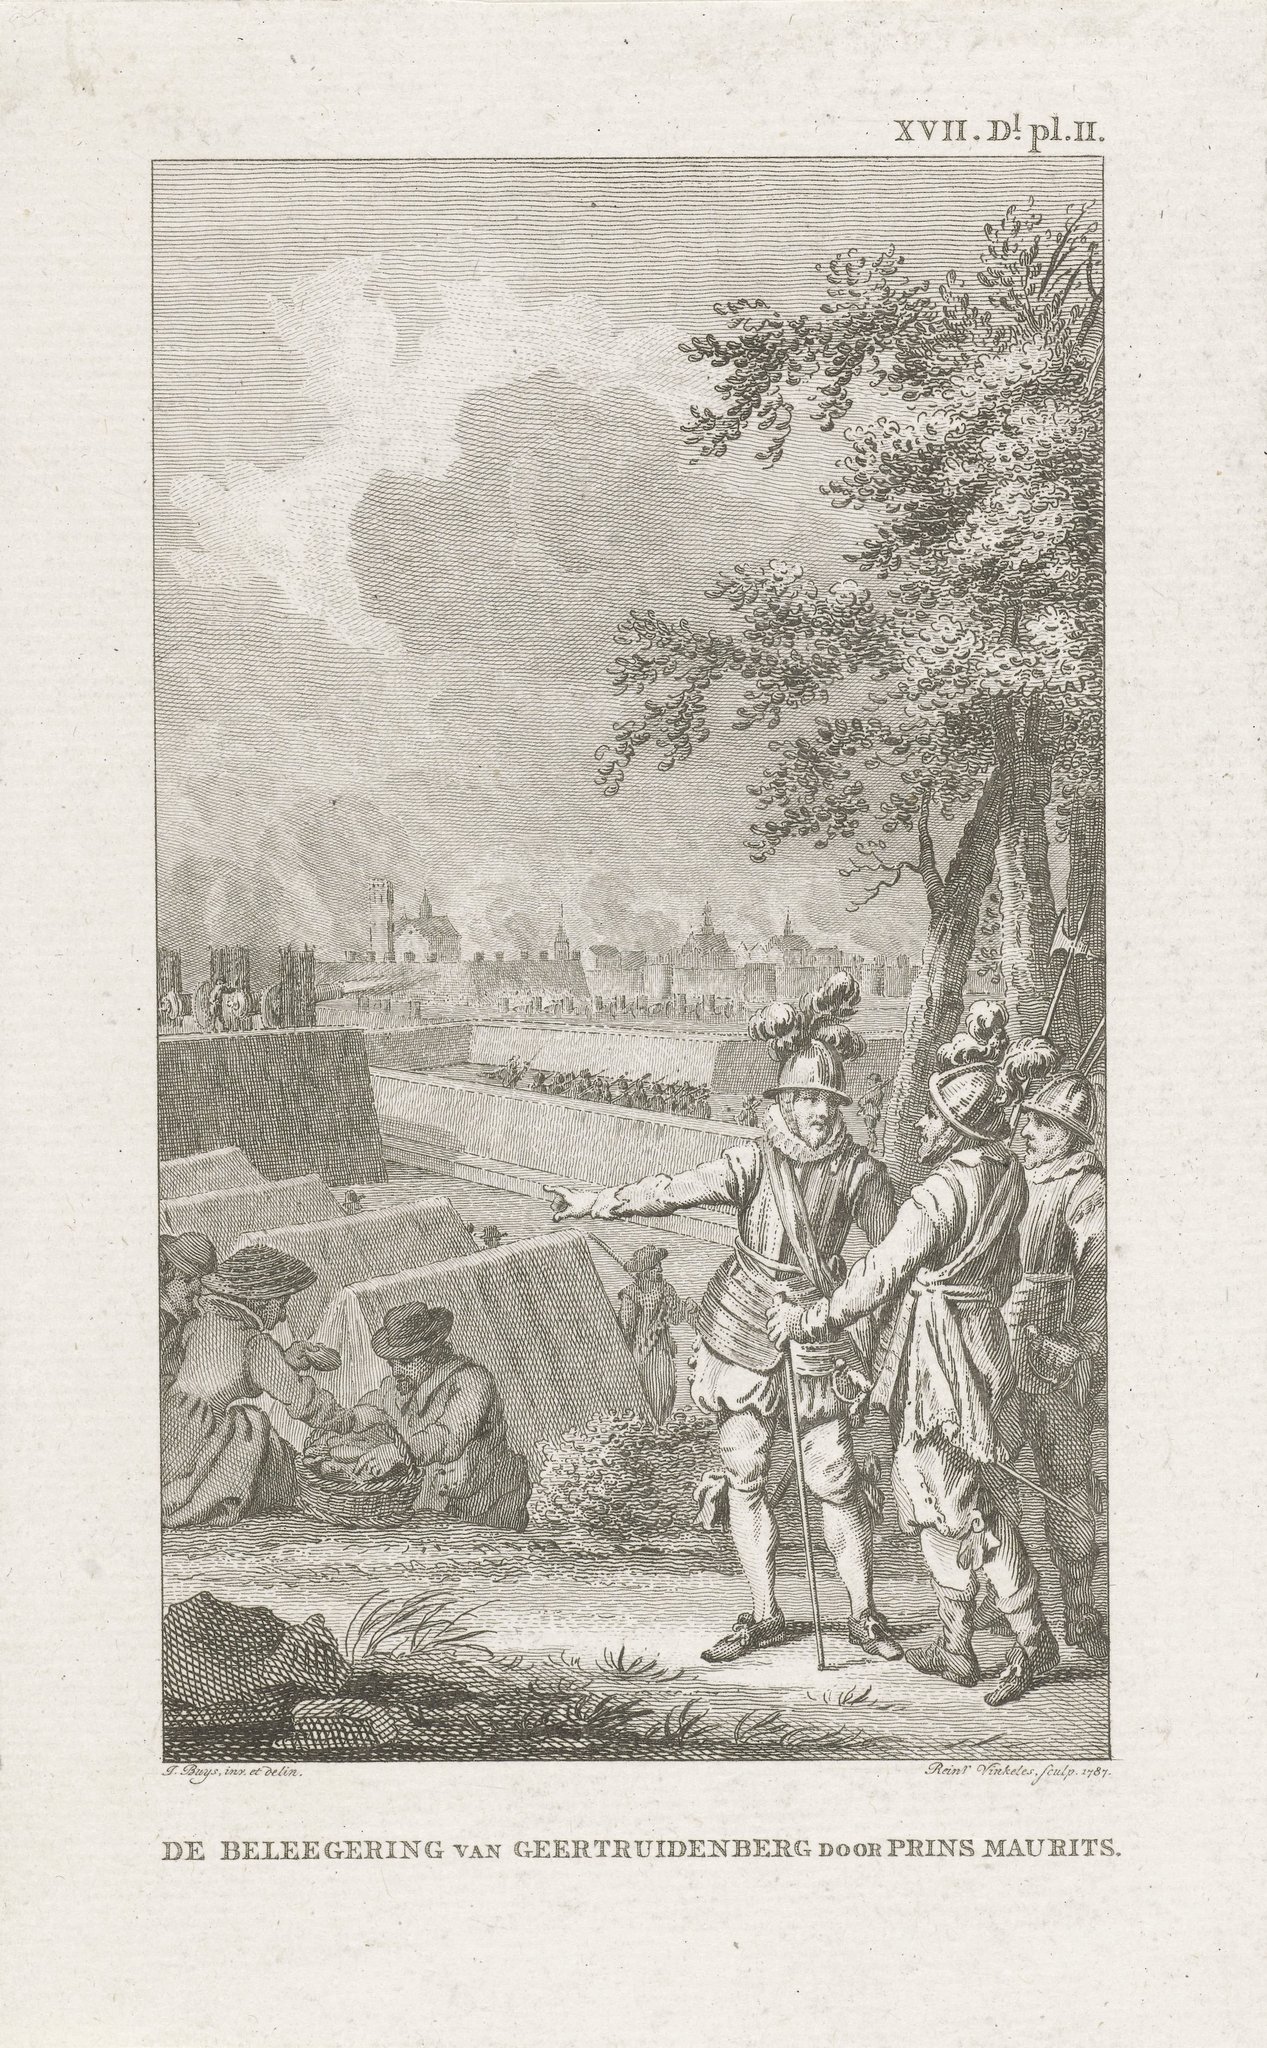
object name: history print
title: De Beleegering van Geertruidenberg door Prins Maurits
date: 1787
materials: paper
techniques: etching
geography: netherlands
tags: the hague, maurice (prince of orange), siege, position war, geertruidenberg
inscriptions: date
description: Gebruikt als illustratie in: Jacobus Kok, Vaderlandsch Woordenboek, Johannes Allart, Amsterdam 1785-1799, 35 delen, dl. XVII, pl. II. Staat met de letter.